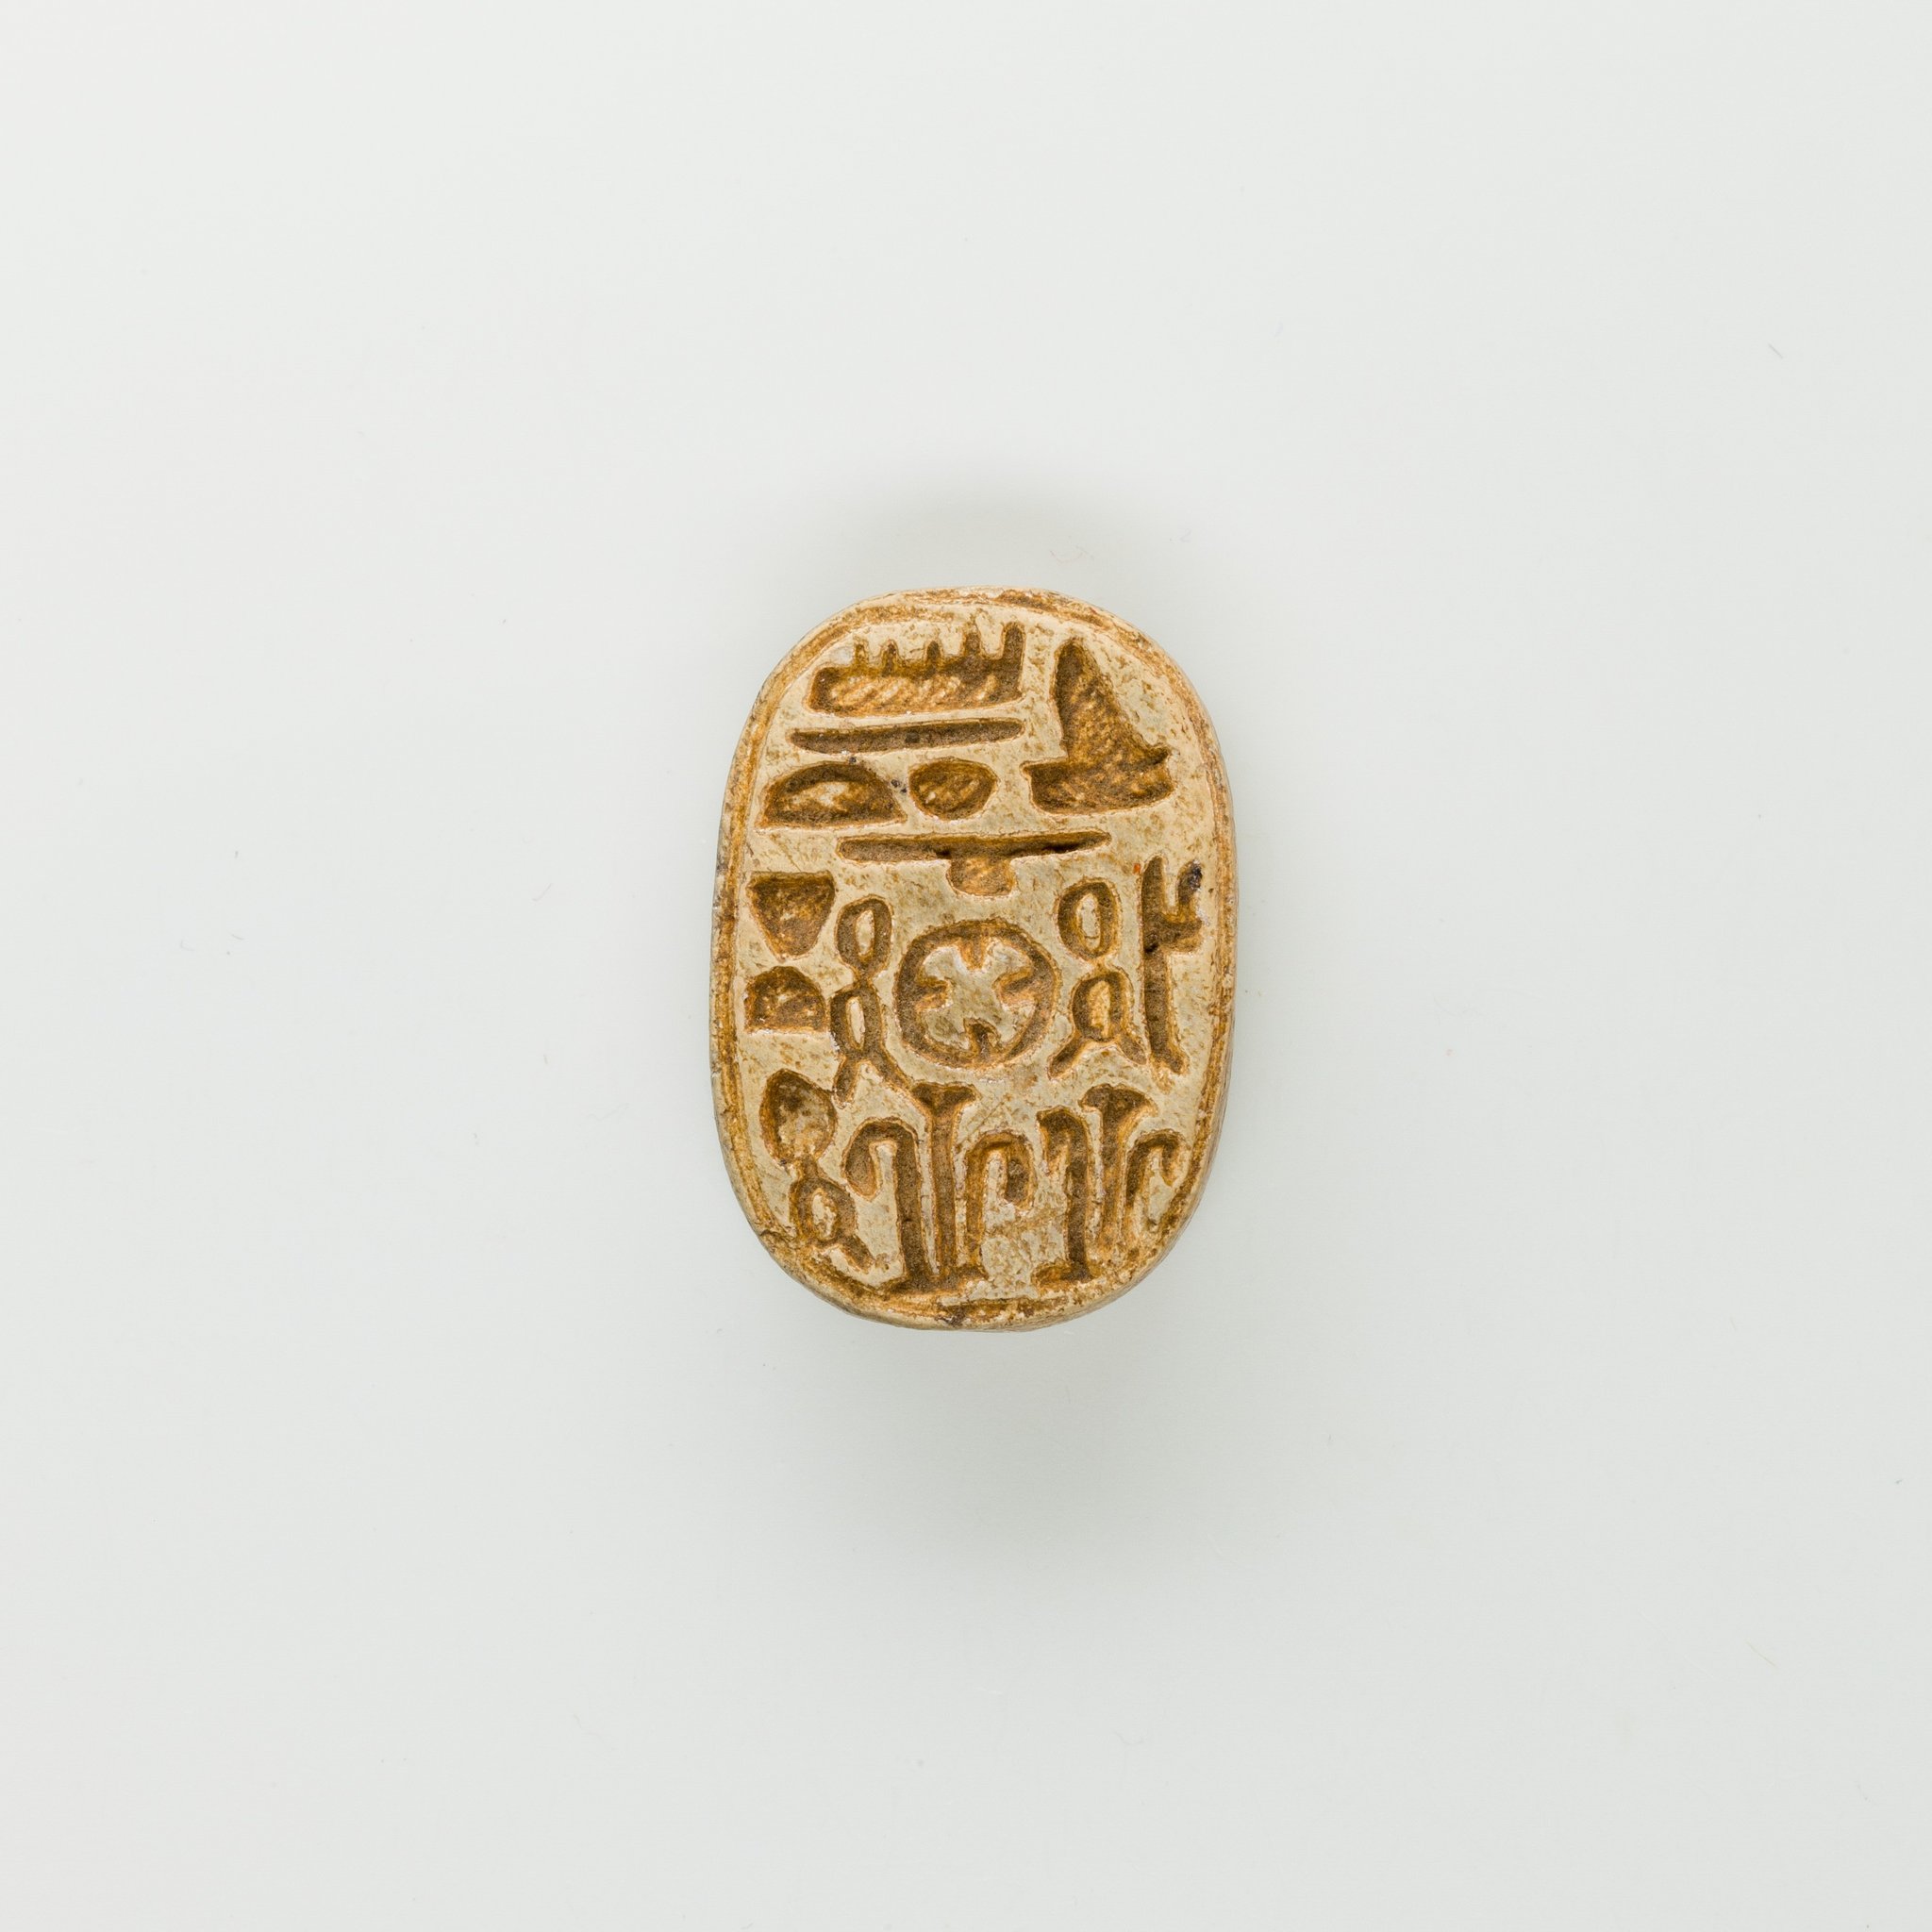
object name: plaque, oval, ramesses ii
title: Oval plaque of Ramesses II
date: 1295-1070 BCE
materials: stone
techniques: glazing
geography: egypt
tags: hieroglyphs